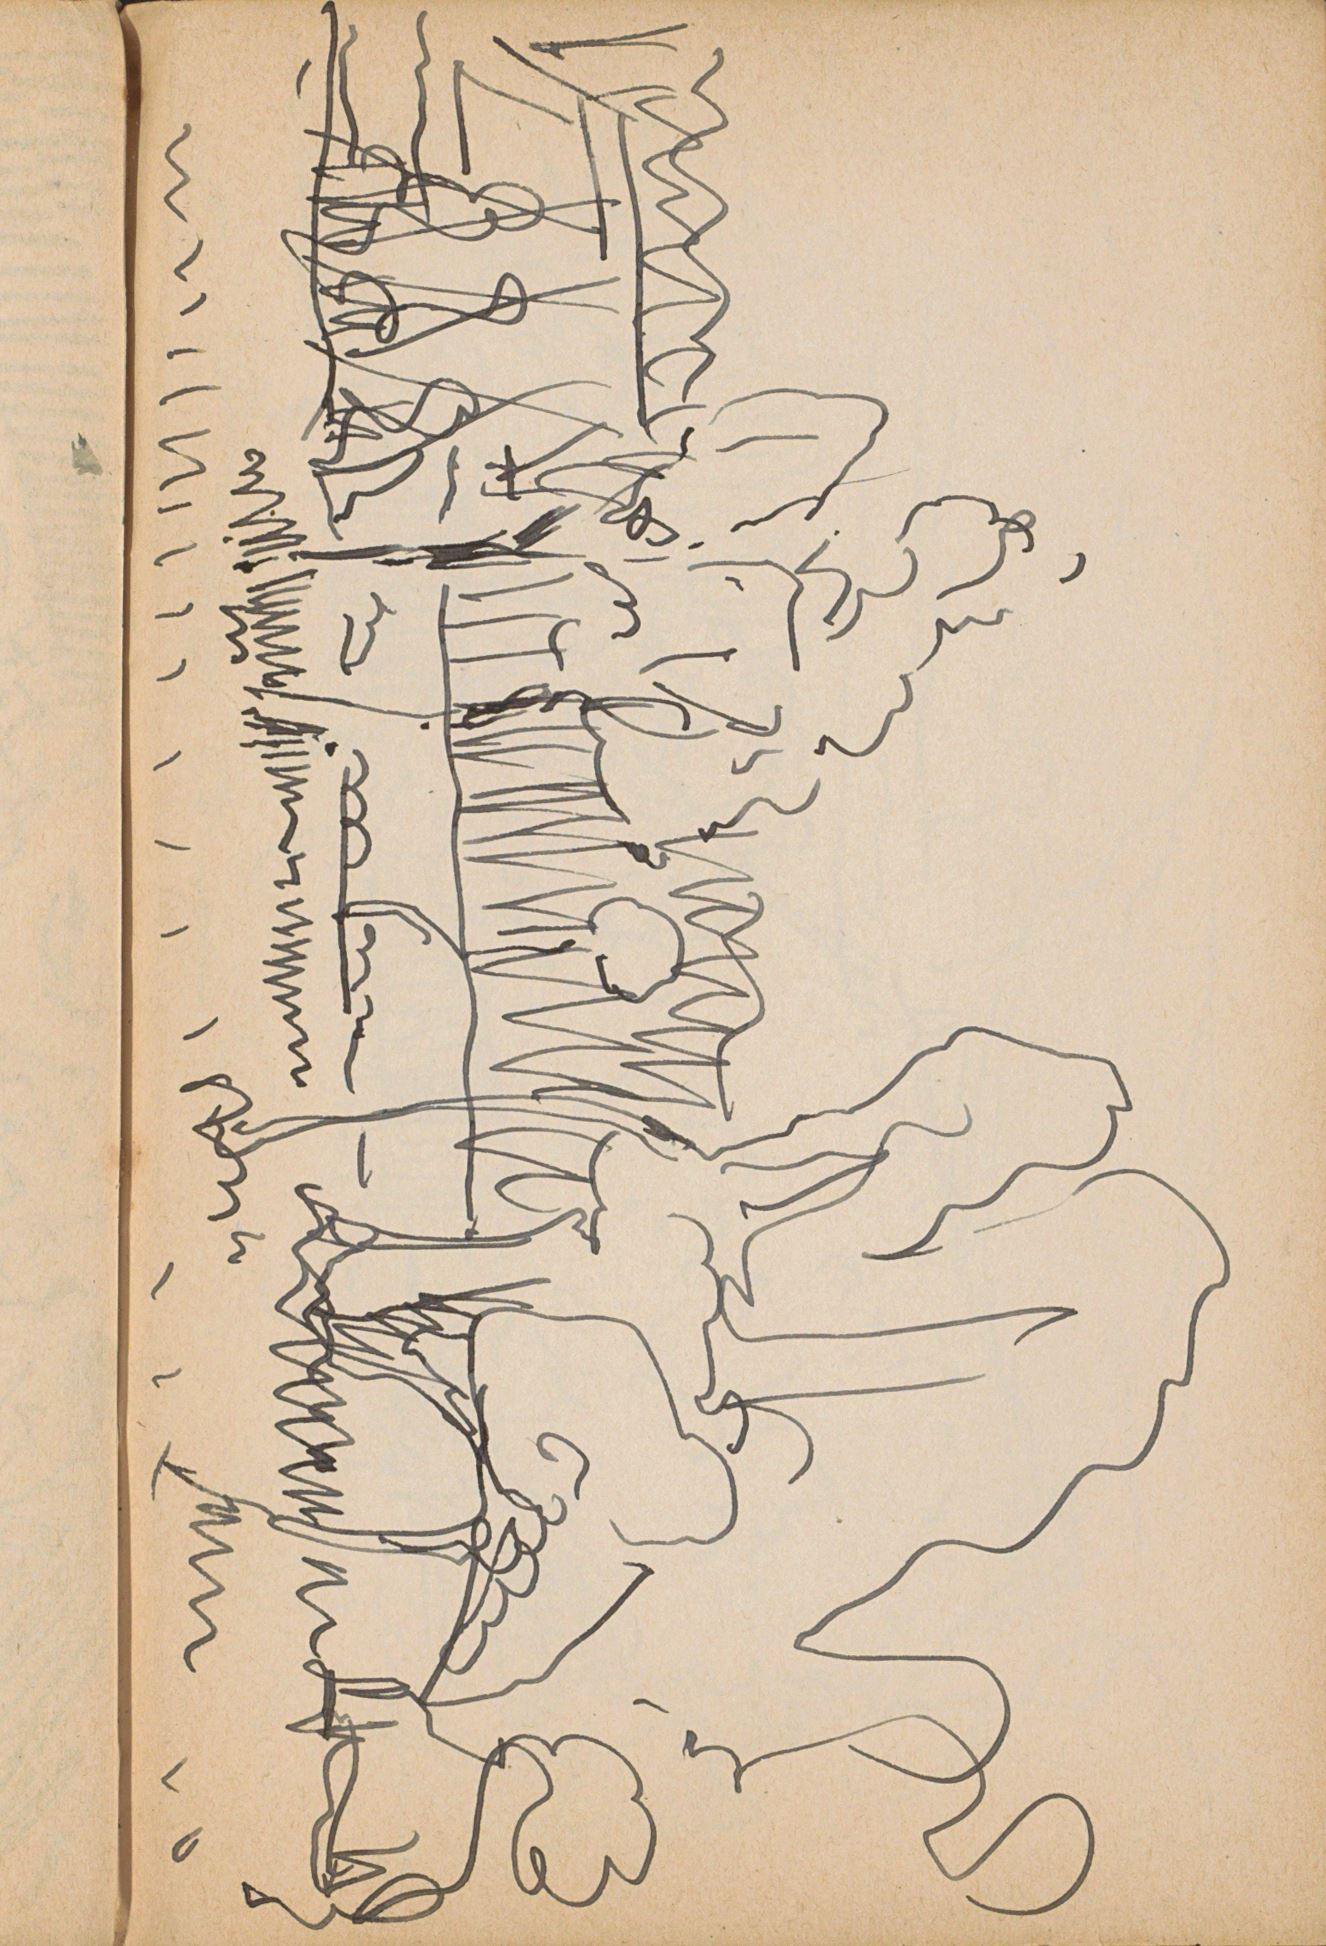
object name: sketchbook leaf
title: Bomen en een tent in een landschap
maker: reijer stolk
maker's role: draughtsman, print maker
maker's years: 1896-1945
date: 1908-1919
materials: ink, paper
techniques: pen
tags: trees, tent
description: Blad 31 recto uit een schetsboek met 33 bladen.